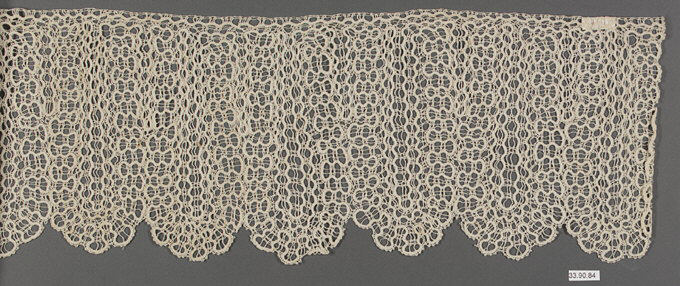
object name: edging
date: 1801-1900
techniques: lace